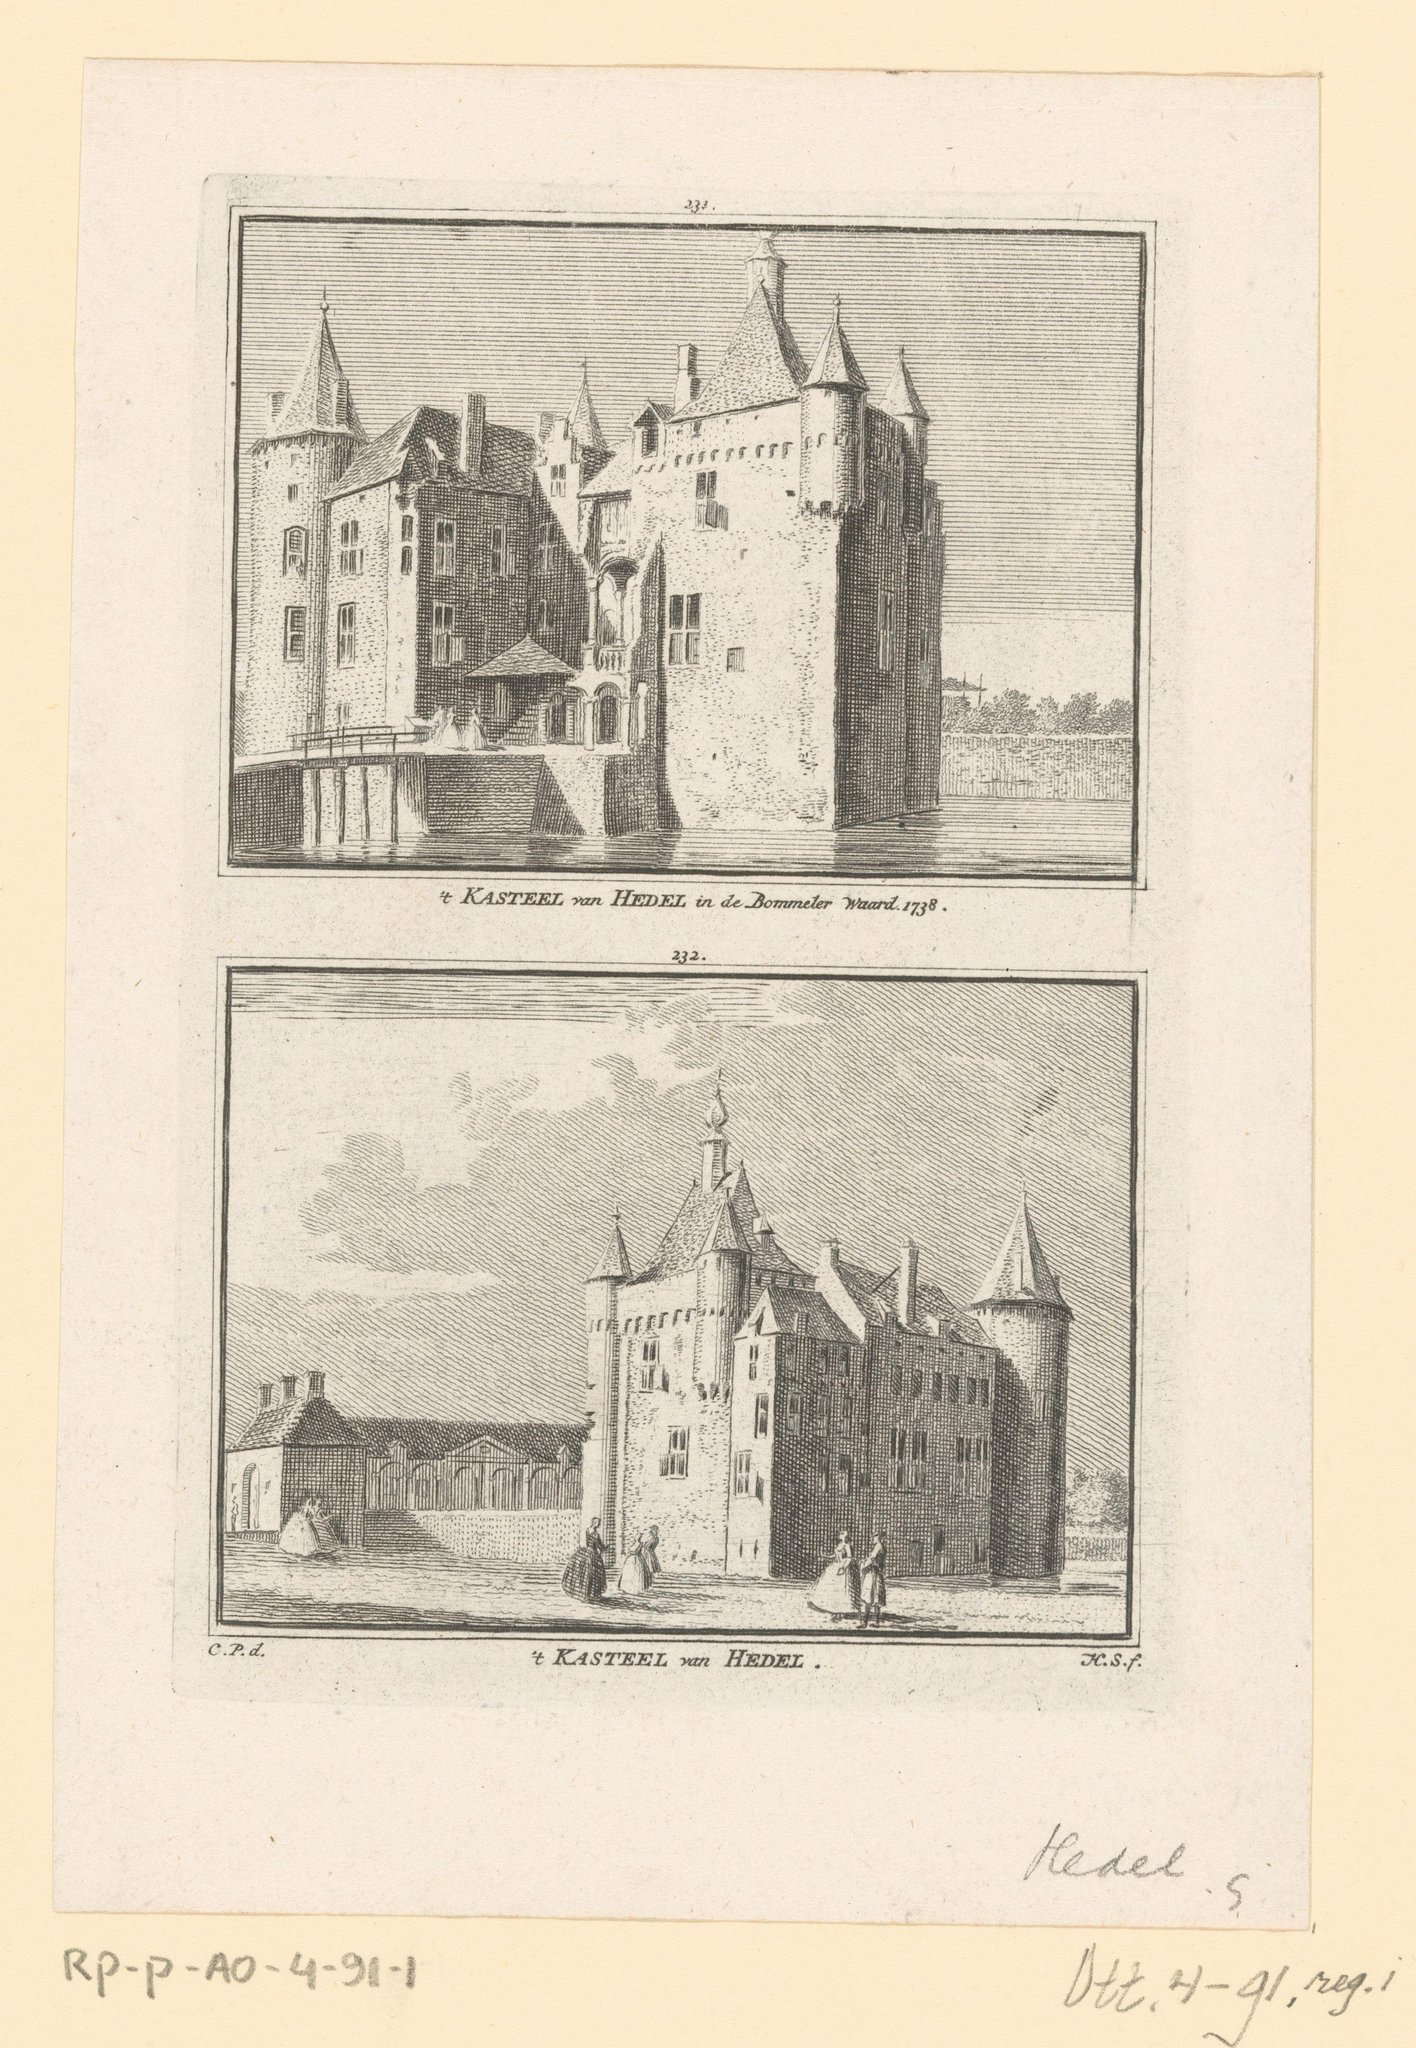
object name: print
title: 't Kasteel van Hedel in de Bommeler Waard. 1738 / 't Kasteel van Hedel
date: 1750-1792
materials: paper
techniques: etching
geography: amsterdam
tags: castle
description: Prent ook gebruikt in: Het verheerlykt Nederland of kabinet van hedendaagsche gezigten van steden, dorpen (…). 9 delen. Amsterdam: Isaak Tirion en weduwe Isaak Tirion, 1745-1774, dl. 3 (1750), ill. 231-232. Of in: Nederlandsche tafereelen; of eene keurige verzameling van negen honderd fraaije gezigten van steden, dorpen, sloten, oudheden (….). 9 delen. Amsterdam: Jan de Groot, 1792, dl. 3, ill. 231-232.